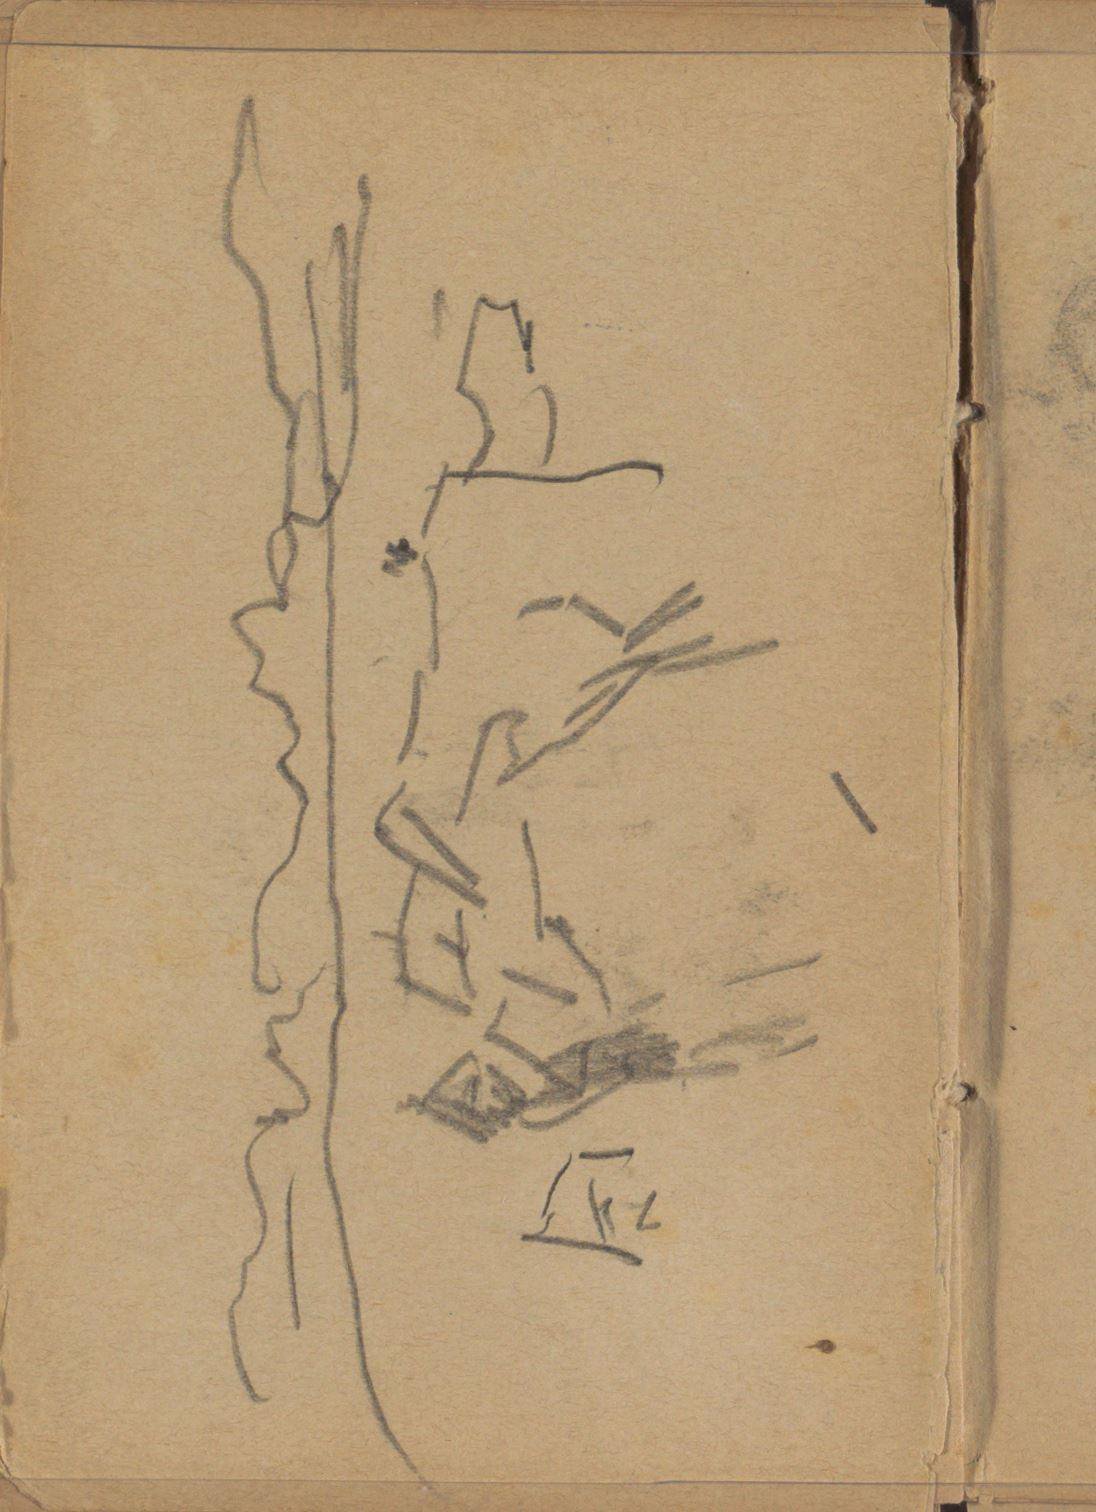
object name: sketchbook leaf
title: Soldaat bij paarden in een landschap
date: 1887-1891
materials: paper, pencil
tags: landscapes, division of armed forces (+ land forces), horse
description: Pagina 63 uit een schetsboek met 83 bladen.